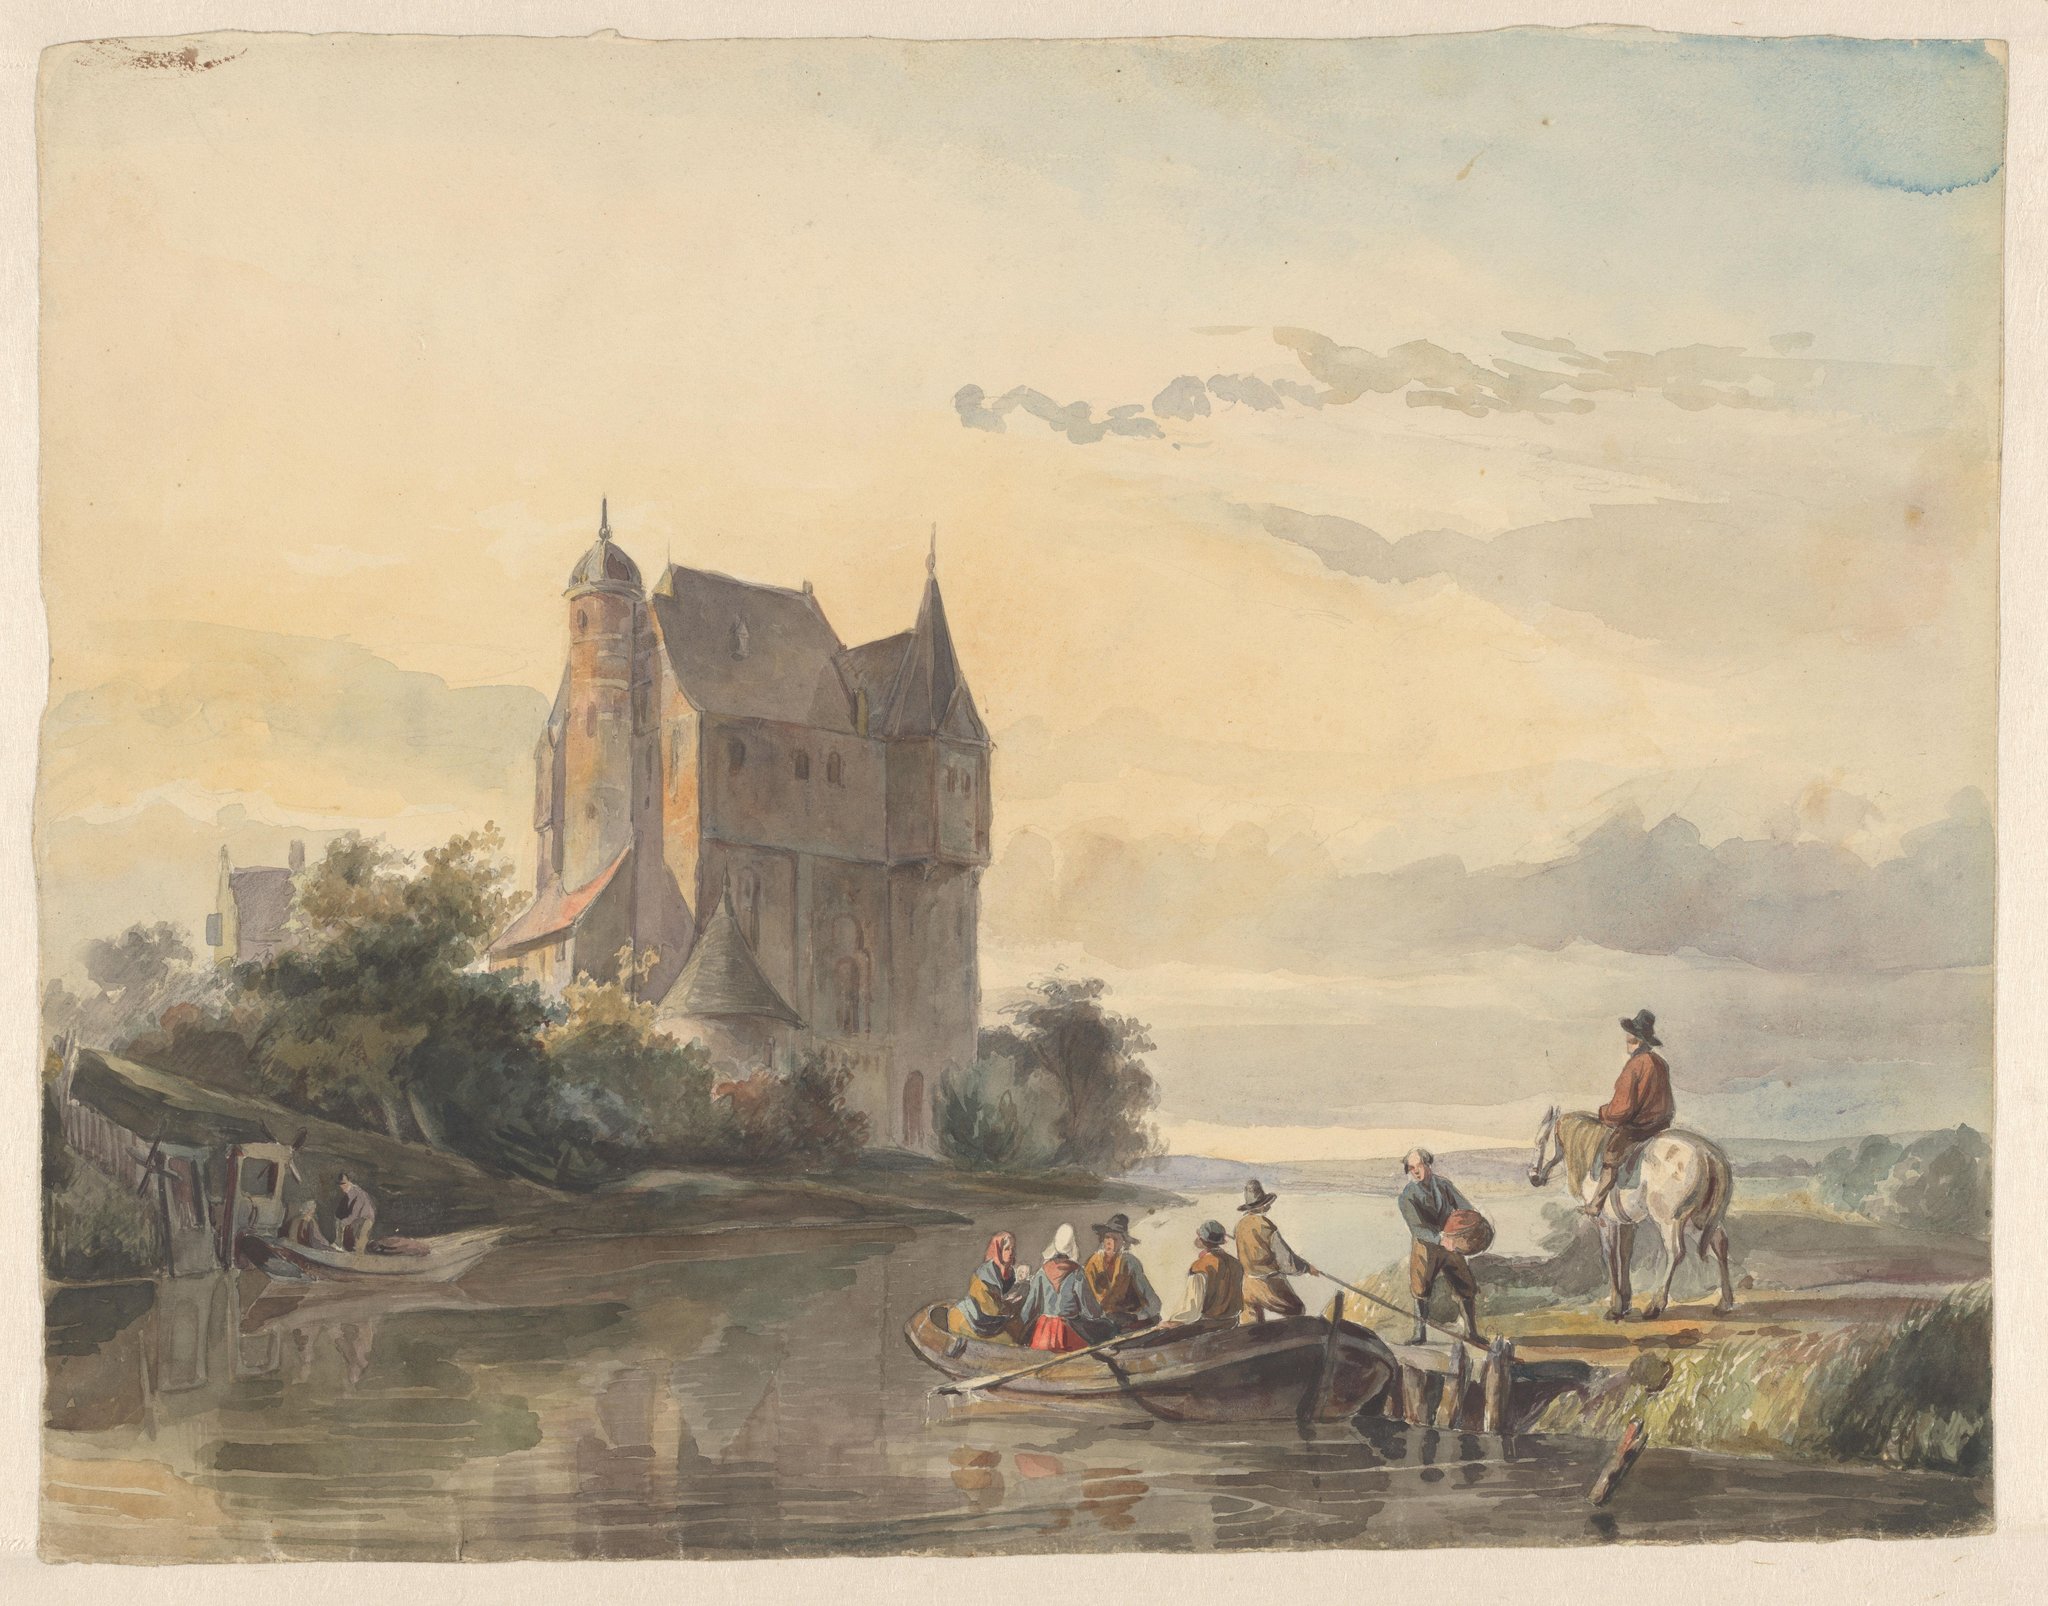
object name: drawing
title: Rivierlandschap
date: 1840-1860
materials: paper, pencil, watercolor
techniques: brush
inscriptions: annotation: ‘Dezelfde Grootte’, number: ‘00:509’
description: Rivierlandschap met figuren in boten en te paard, en gebouwen op de linkeroever